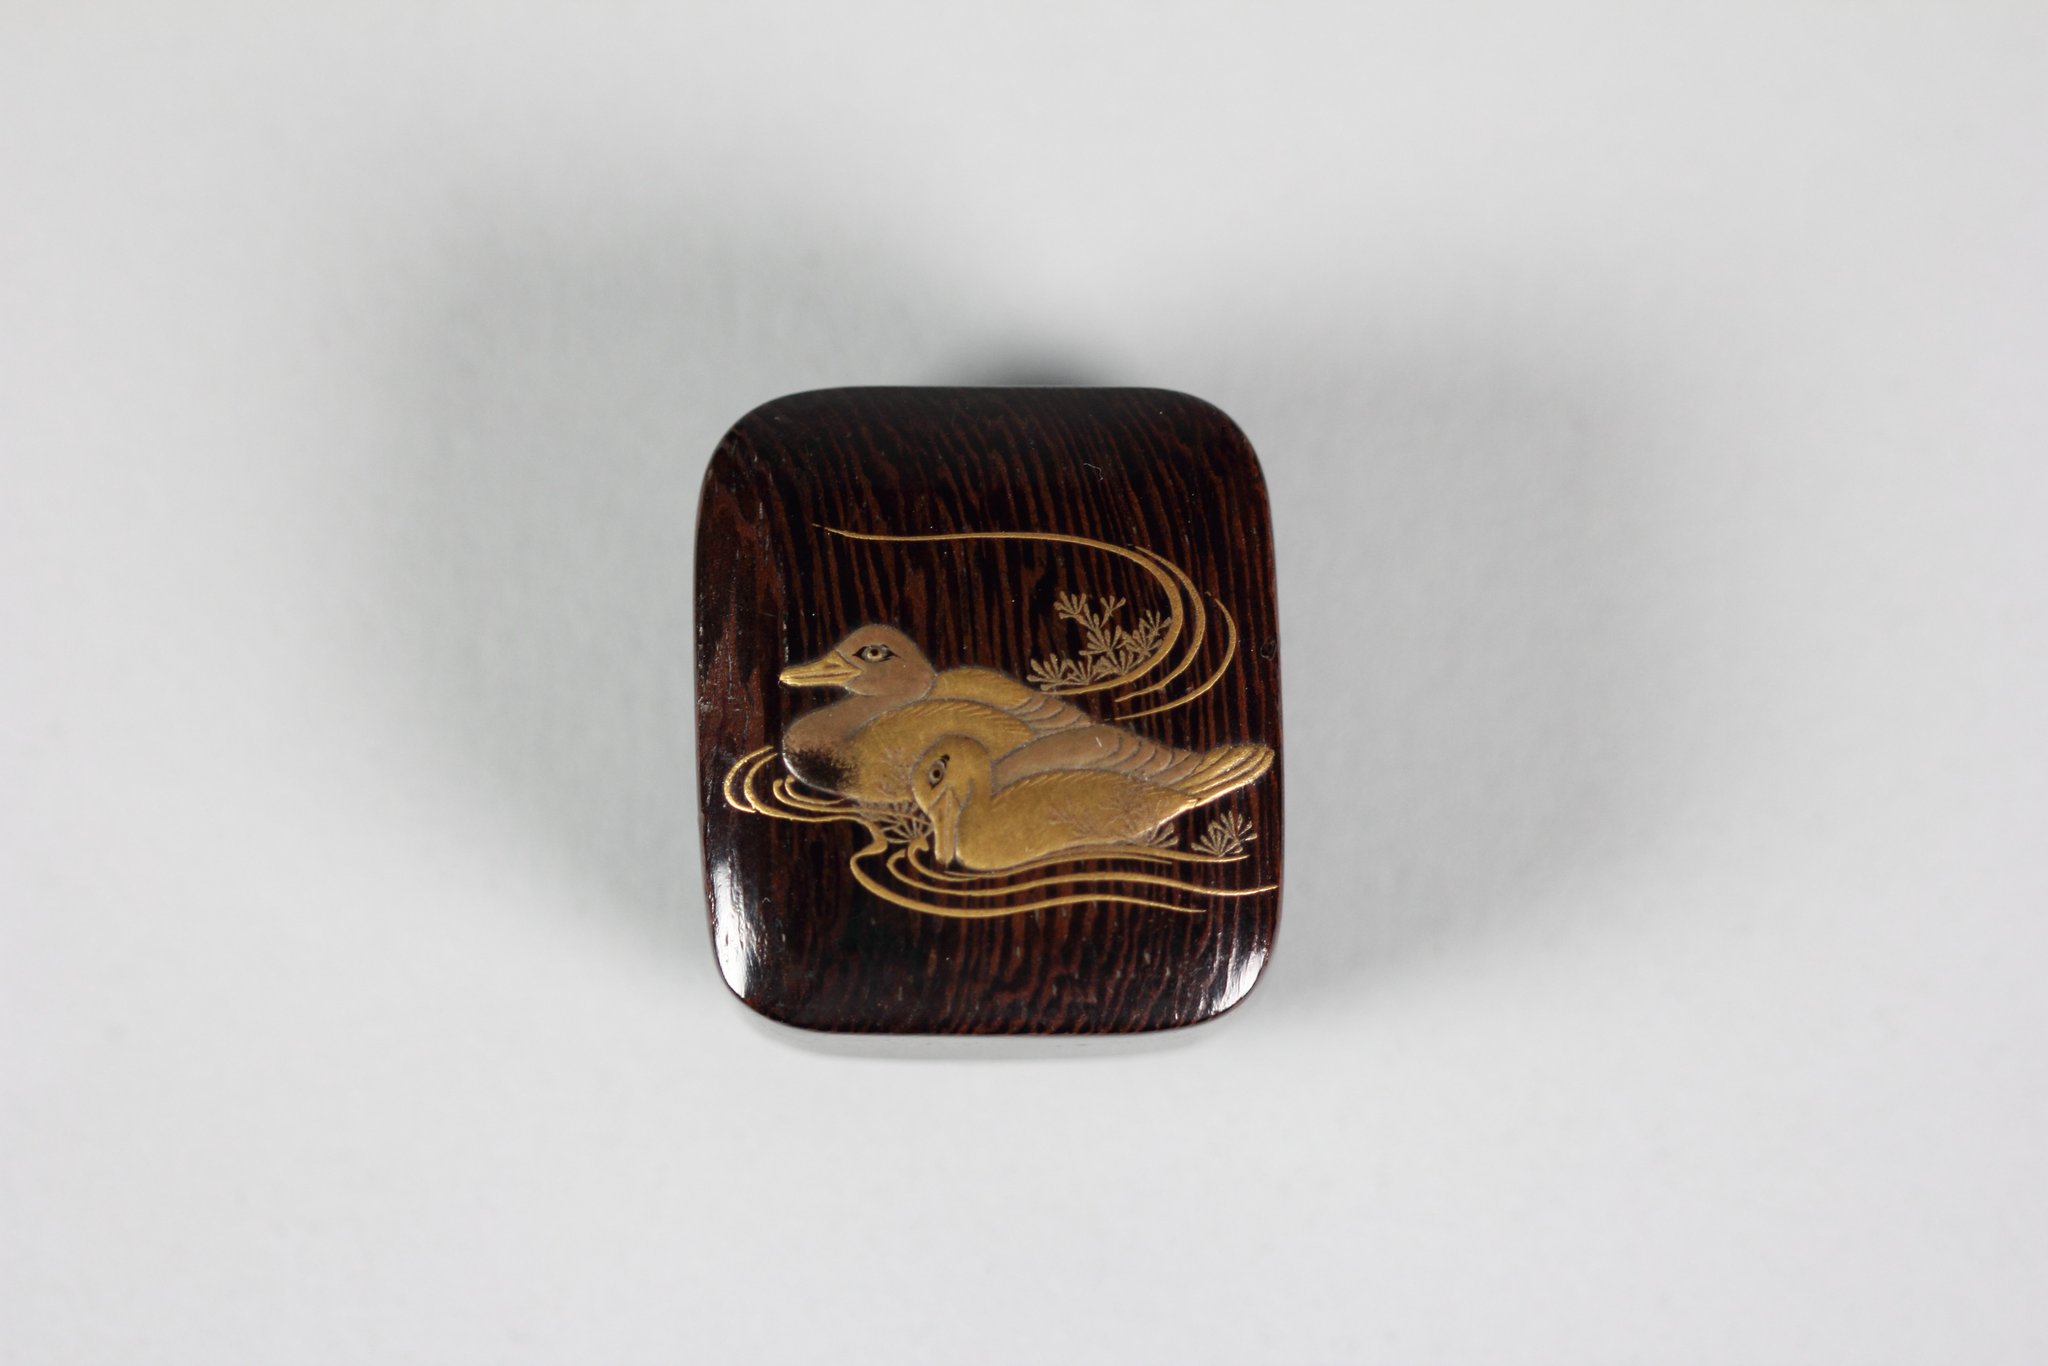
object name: netsuke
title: Netsuke of Two Ducks Swimming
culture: japanese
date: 1801-1900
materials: gold, lacquer, wood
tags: ducks